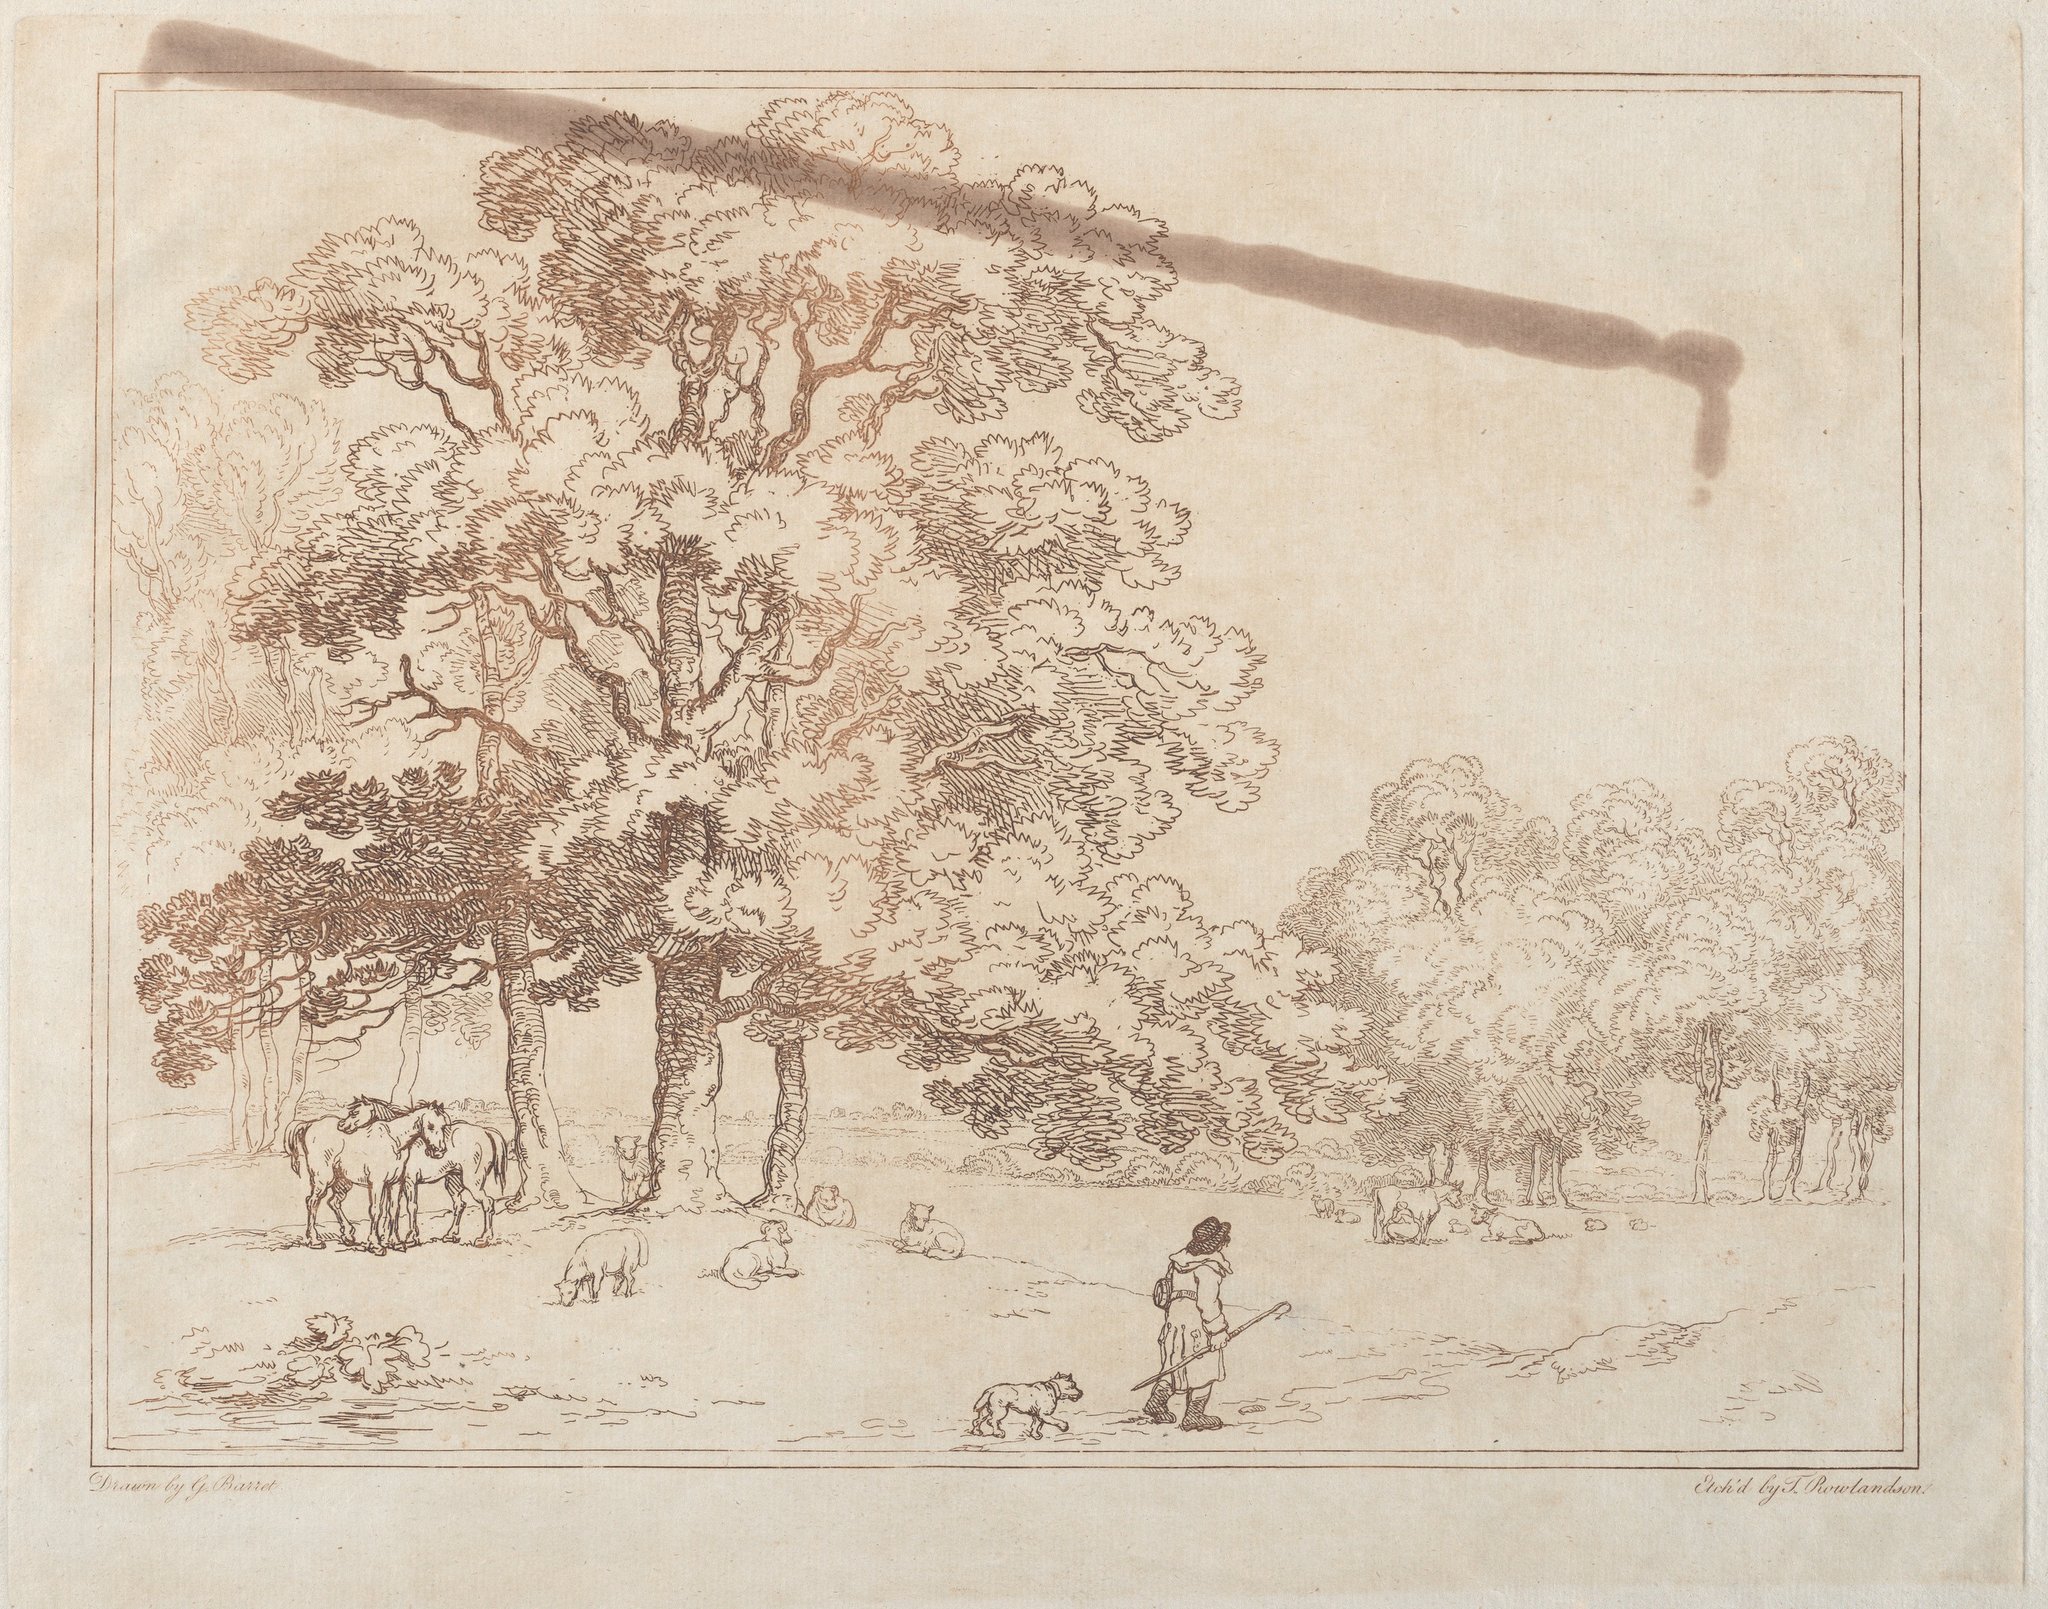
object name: print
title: A Park Landscape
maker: thomas rowlandson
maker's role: artist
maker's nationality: british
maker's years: 1757-1827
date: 1783-1789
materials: ink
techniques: aquatint, etching, printing